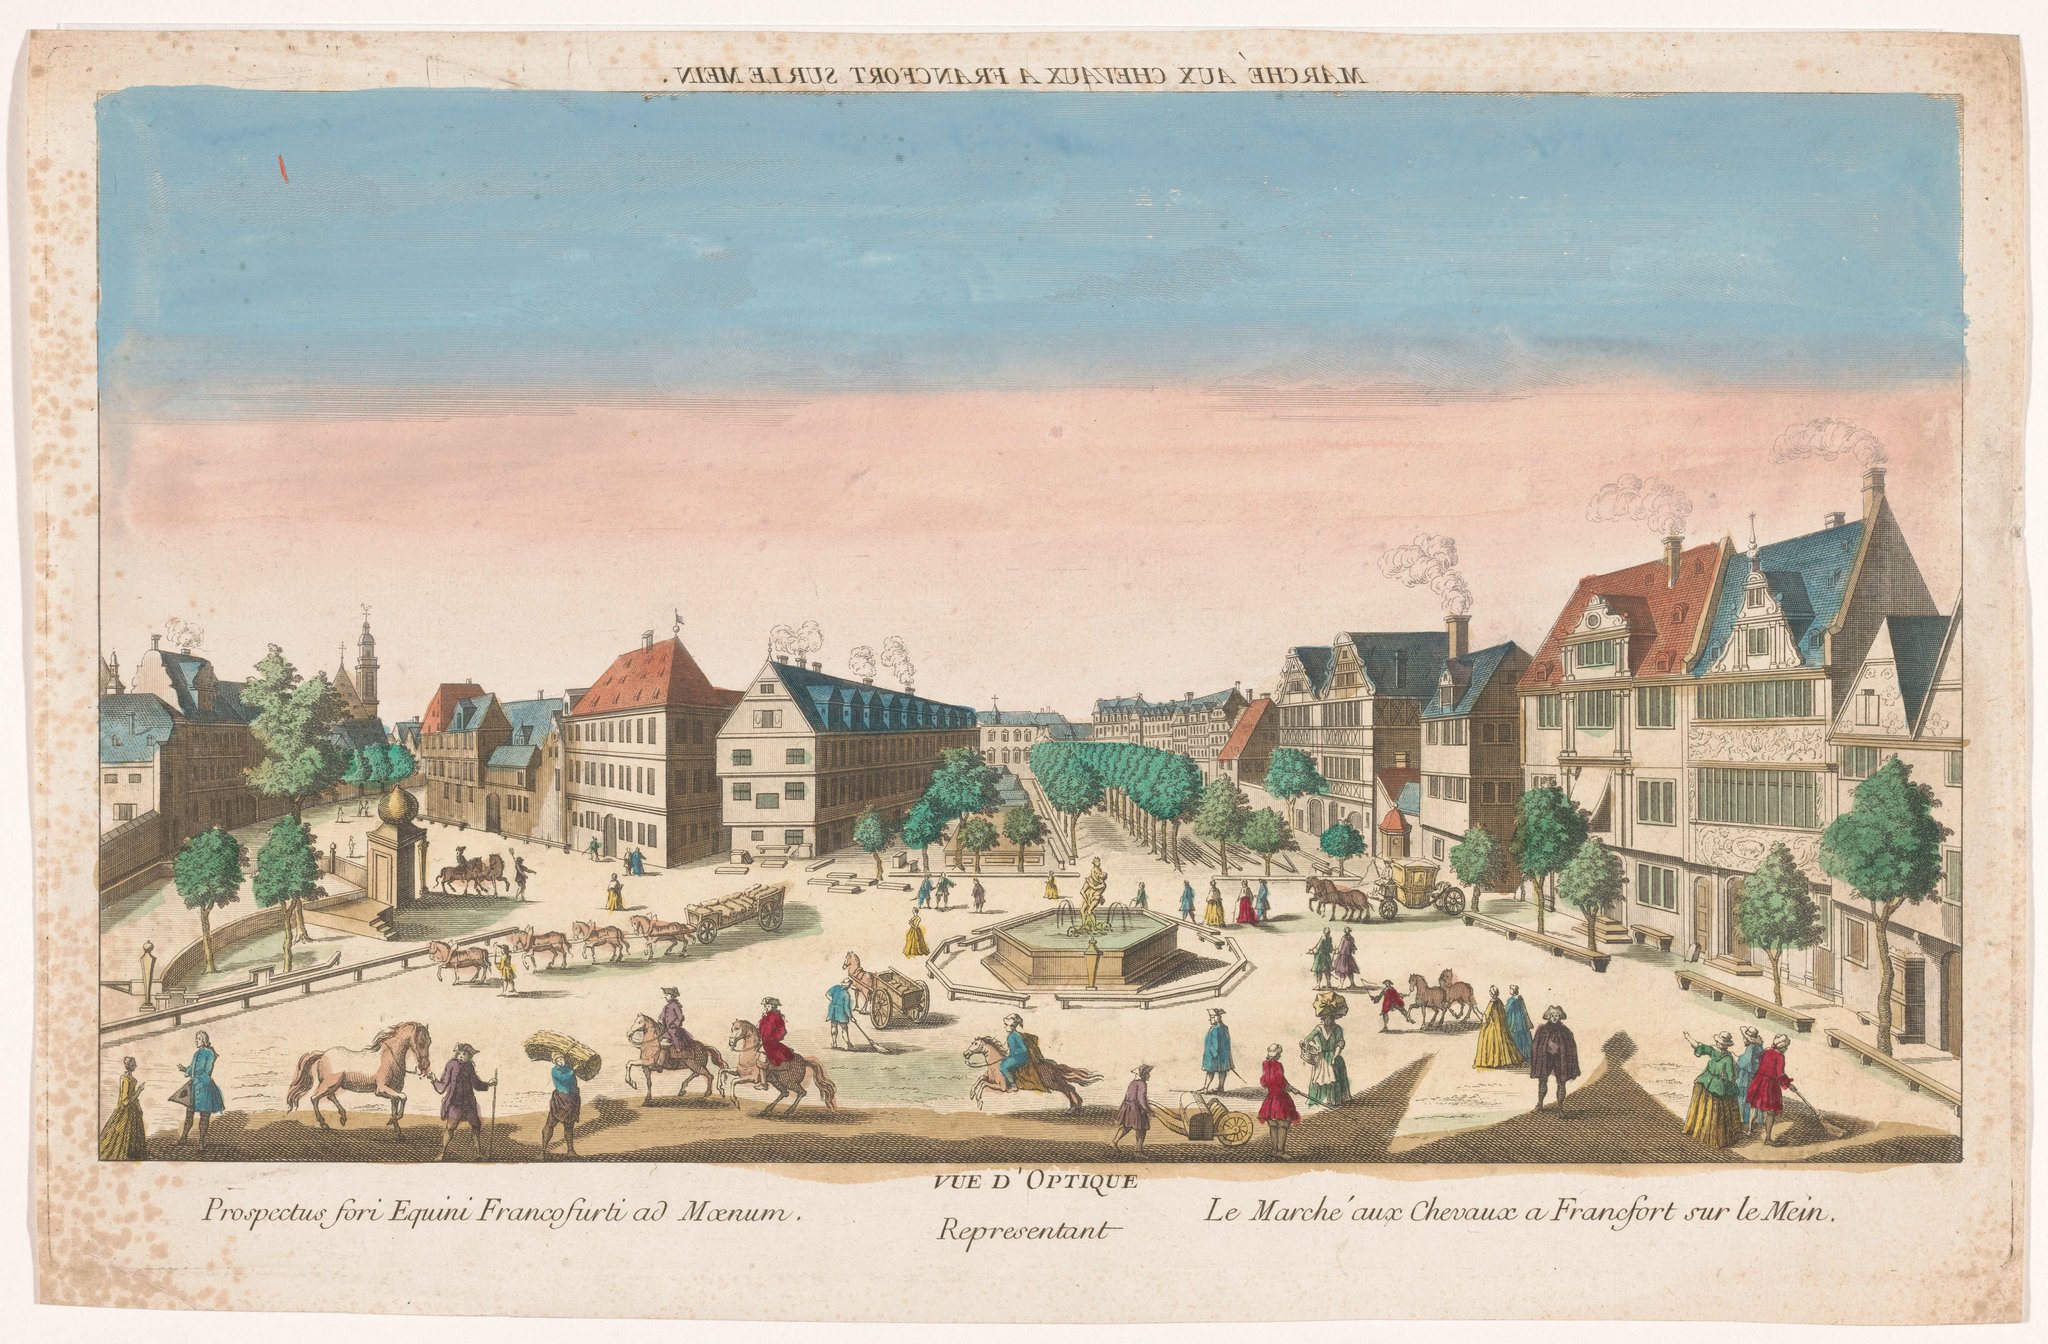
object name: print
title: Gezicht op de Rossmarkt te Frankfurt am Main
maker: Anonymous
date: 1700-1799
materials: paper, watercolor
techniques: brush, etching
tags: avenue, boulevard, promenade, esplanade (+ city(-scape) with figures, staffage), church (exterior), square, place, circus, etc. (+ city(-scape) with figures, staffage)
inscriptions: watermark, collector's mark: Lugt 2233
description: In het midden een laan met kastanjebomen en links de St.-Katharinen-Kirche.